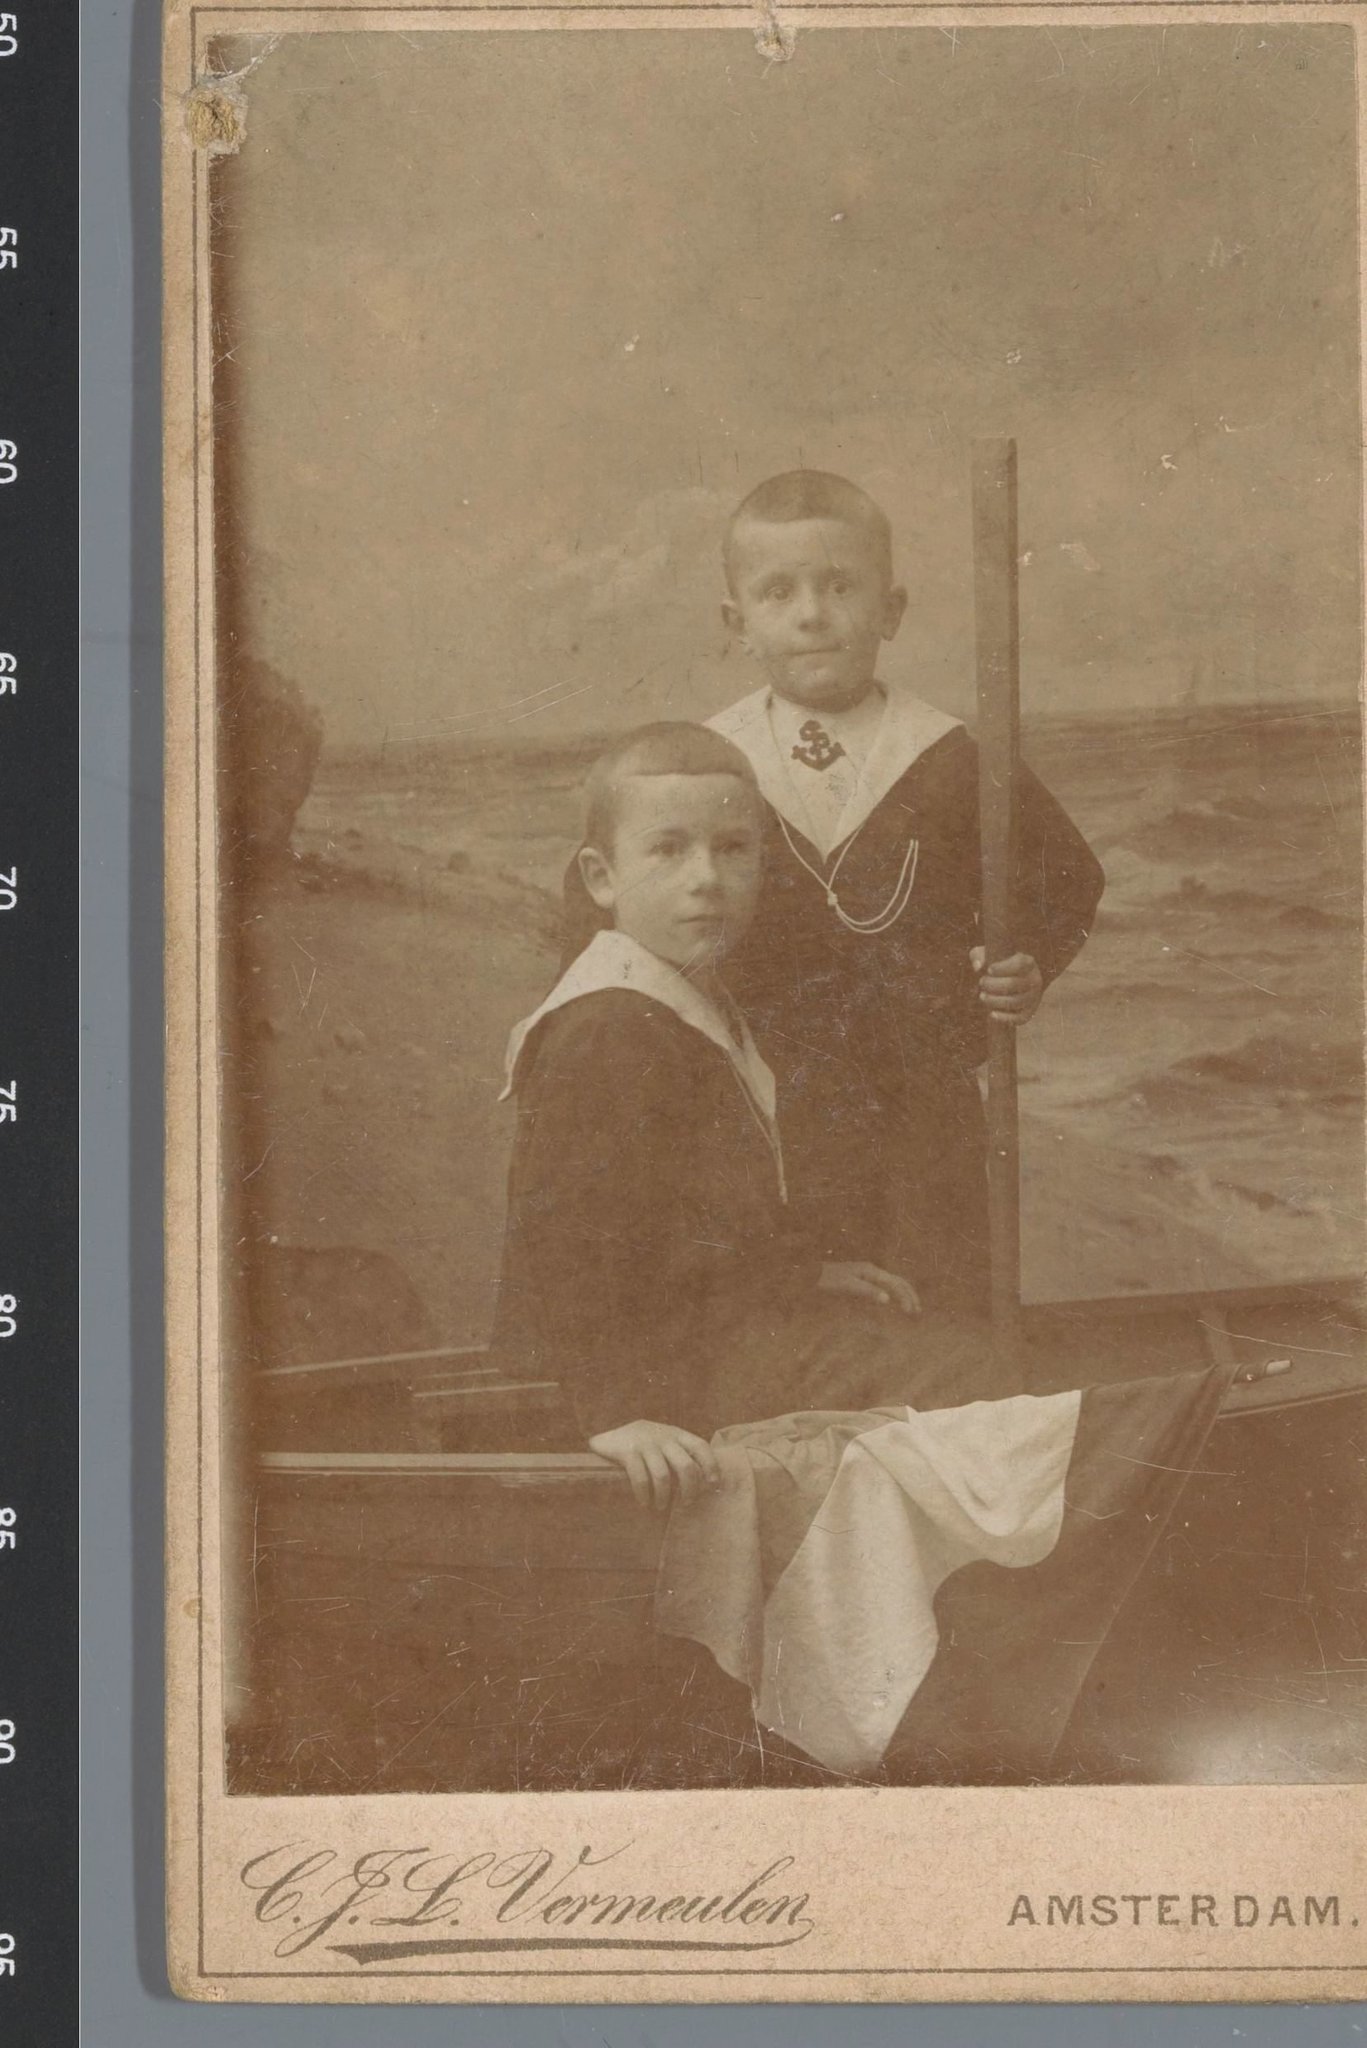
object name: carte de visite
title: Portret van twee onbekende jongens, verkleed als matrozen in een boot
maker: cornelis johannes lodewicus vermeulen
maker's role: fotograaf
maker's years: 1861-1936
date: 1888-1896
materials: cardboard, photographic support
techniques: collodion silver print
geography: amsterdam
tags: ensemble of pieces of clothing: sailor suit, boy (child between toddler and youth) (+ two persons), historical persons, (playing with) boats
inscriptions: inscription: ‘Photographische/ ATELIERS/ C. J. L. Vermeulen/ Heerenstraat 6,/ Heiligenweg/ hoek Singel/ AMSTERDAM,/ Specialiteit in vergrootingen.’